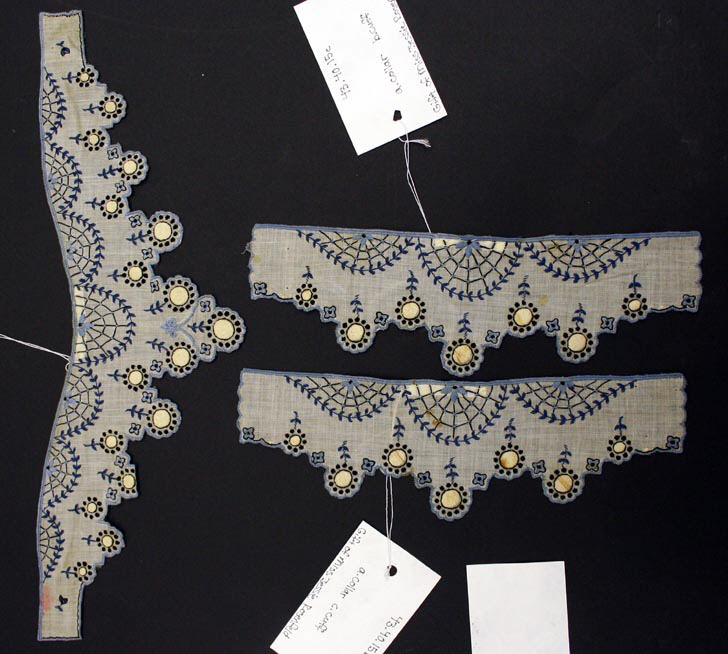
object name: accessory set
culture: american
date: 1700-1943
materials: cotton